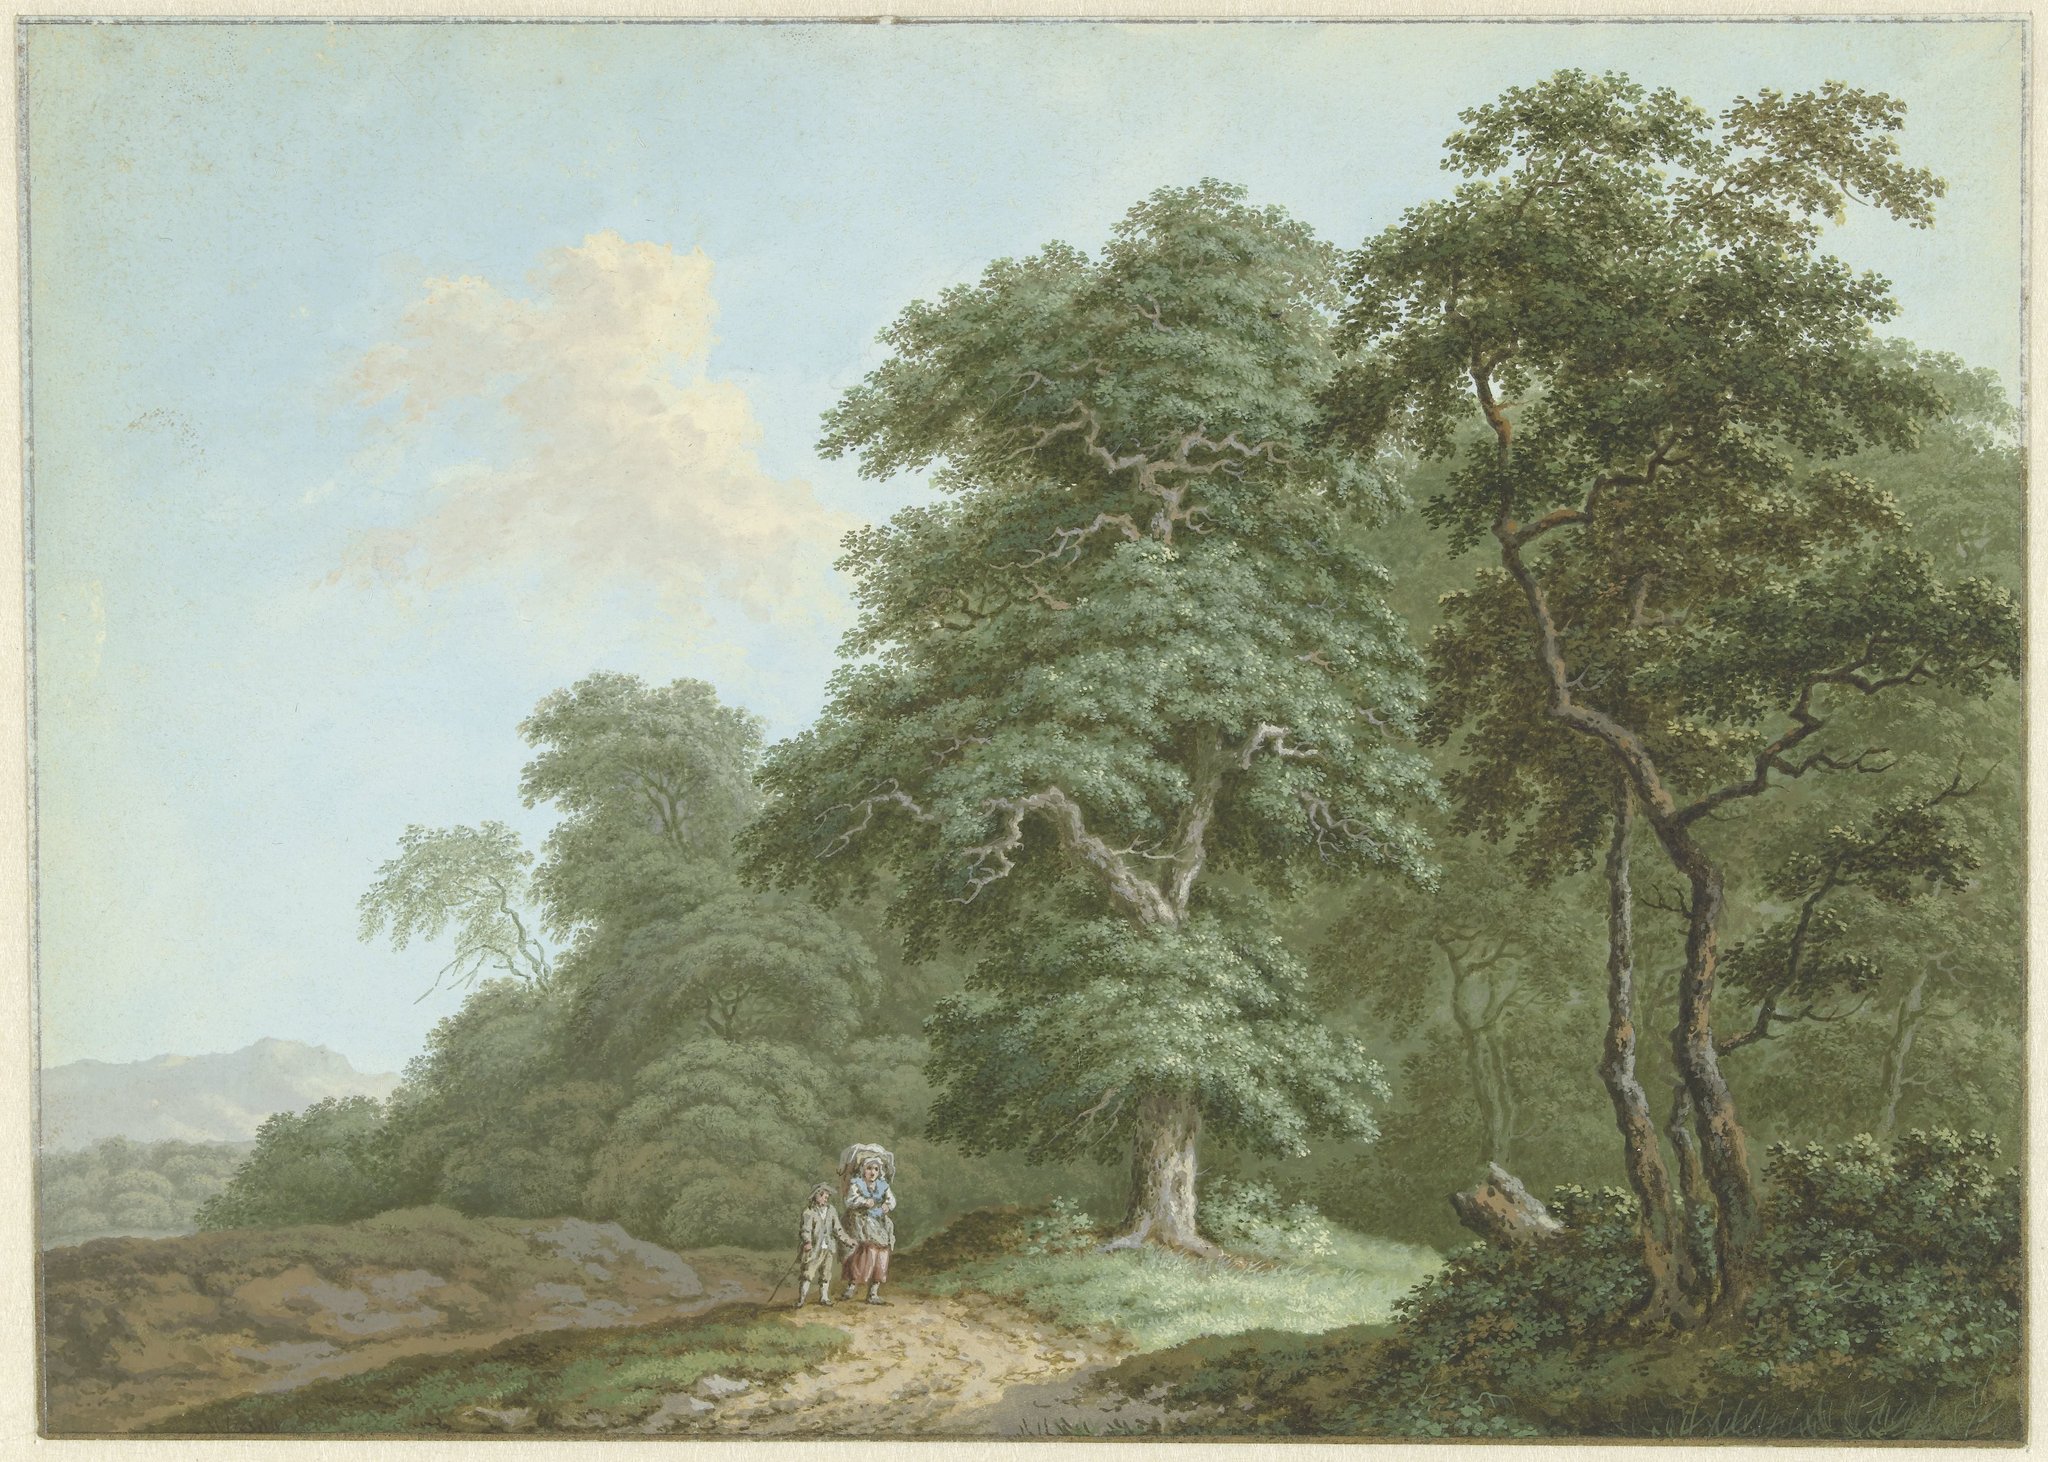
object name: drawing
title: Landschap met vrouw en jongetje op een landweg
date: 1700-1800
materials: gouache, paper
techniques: brush